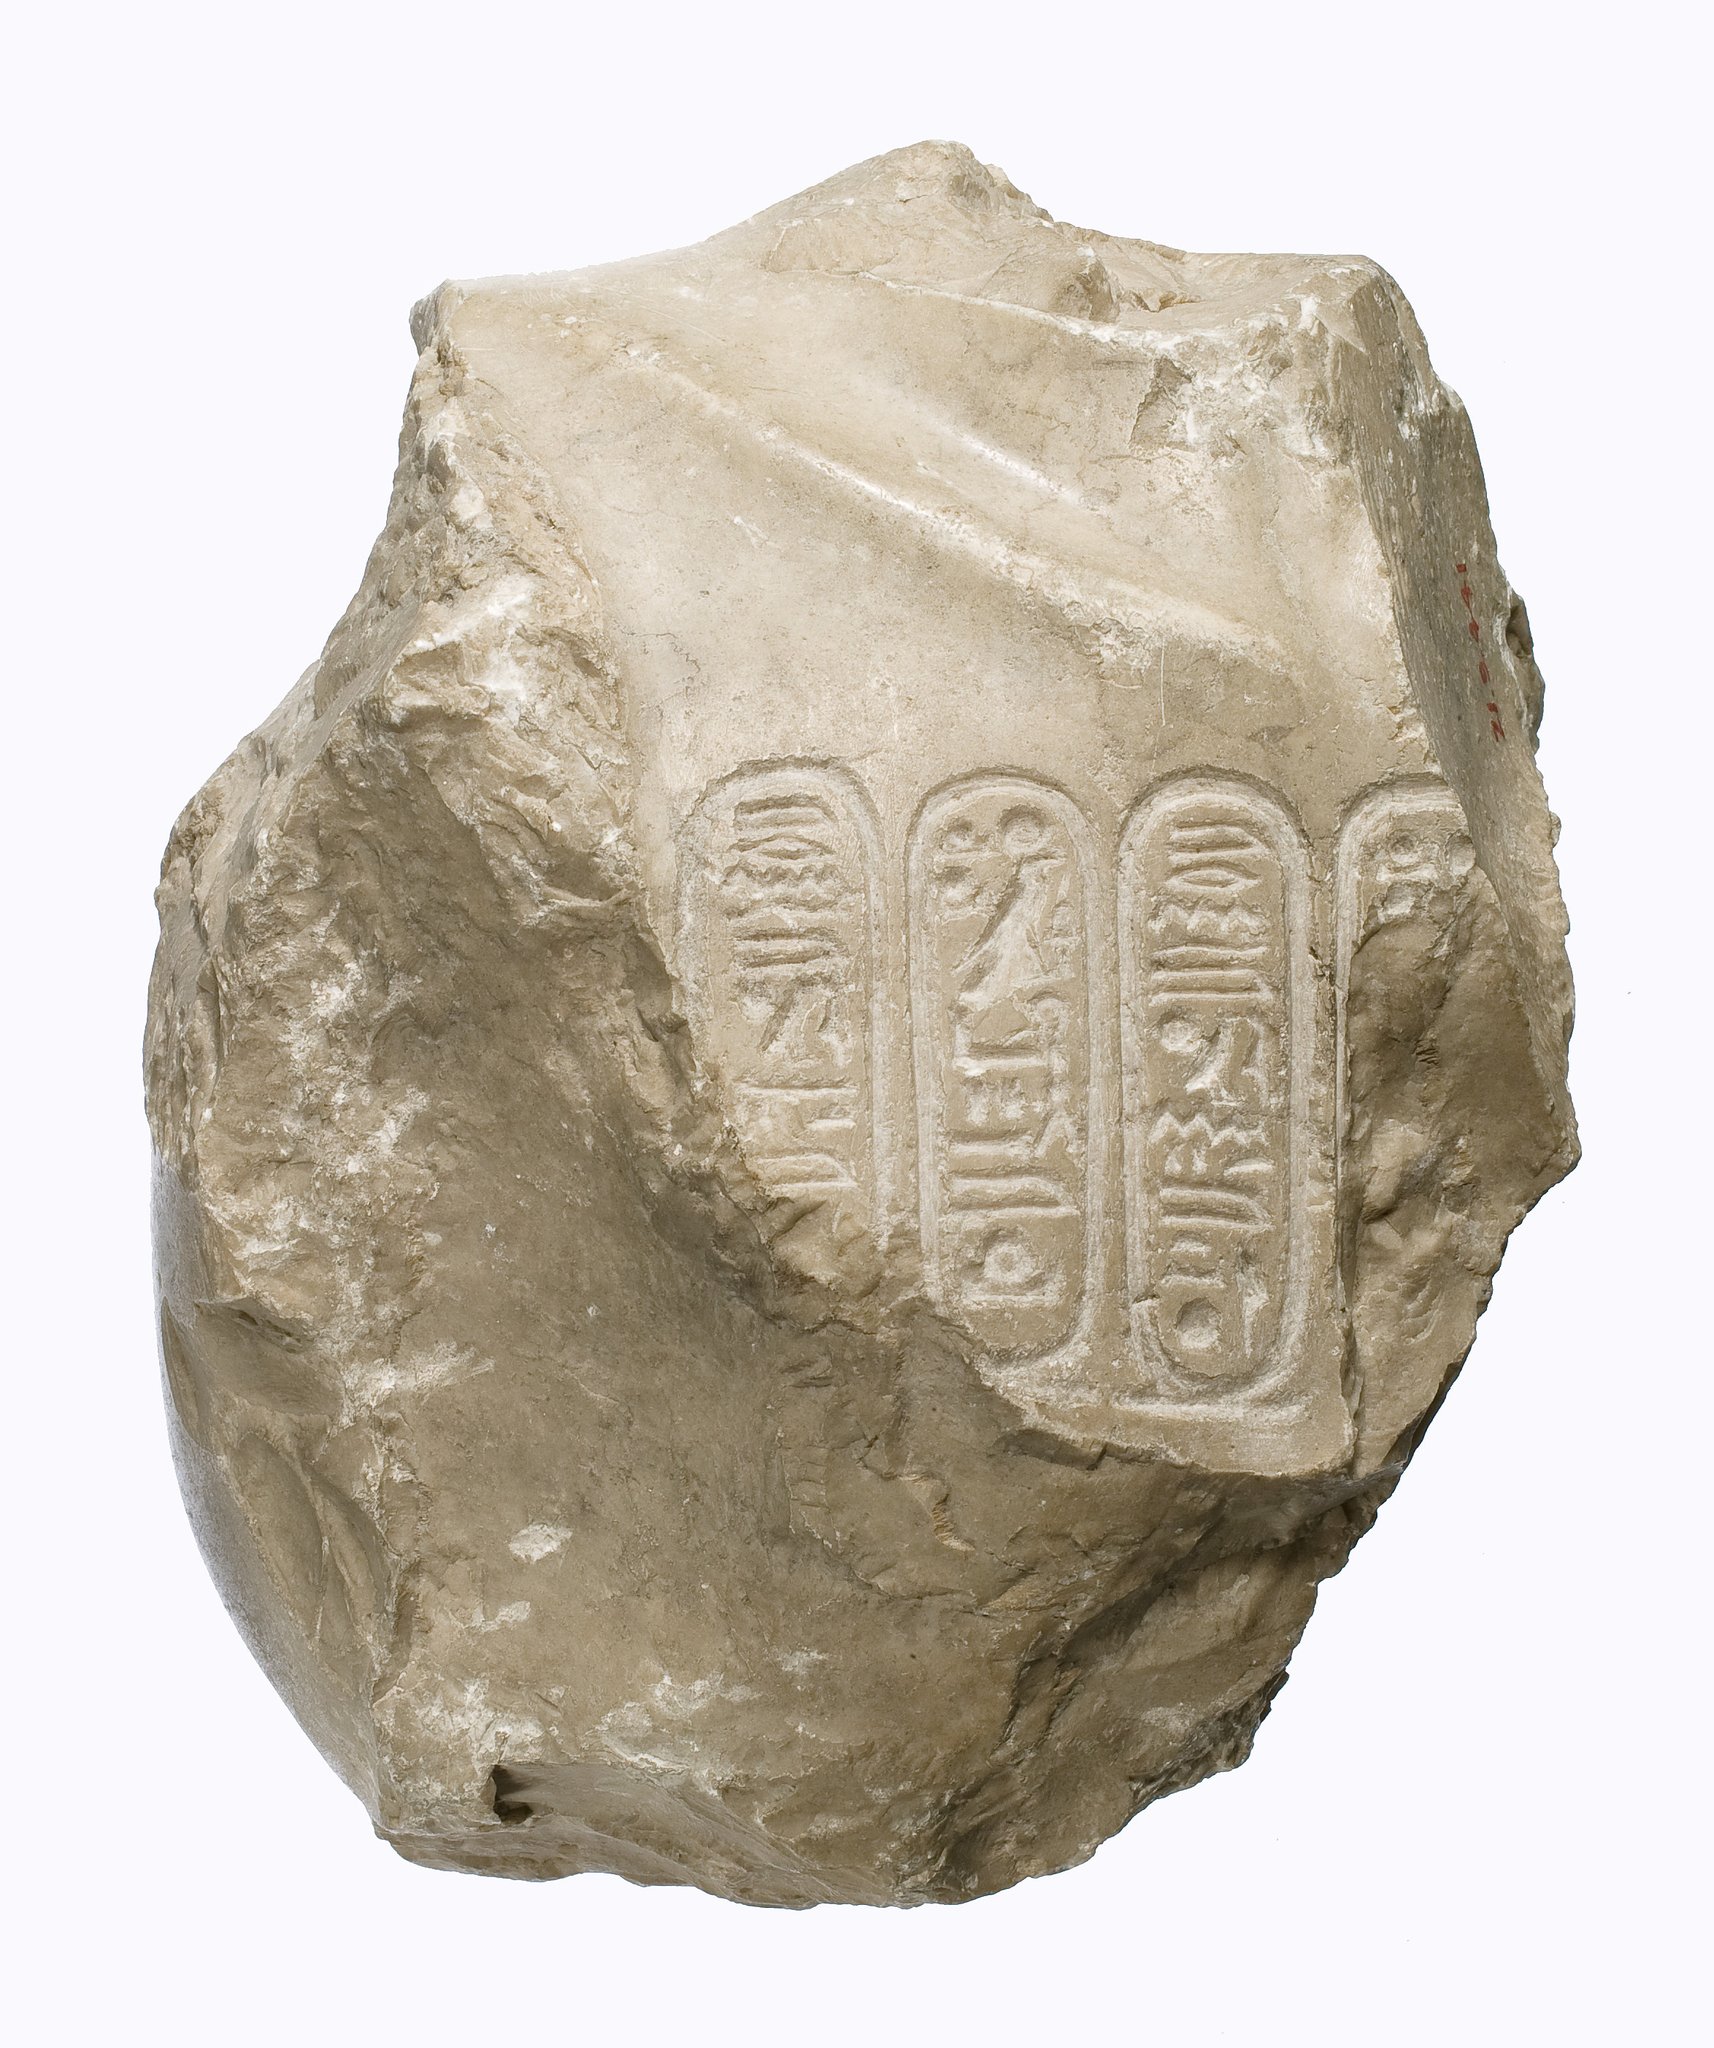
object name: akhenaten prostrate, right chest, aten cartouch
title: Right chest of Akhenaten prostrate, with Aten cartouches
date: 1352-1336 BCE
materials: limestone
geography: egypt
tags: cartouches,hieroglyphs